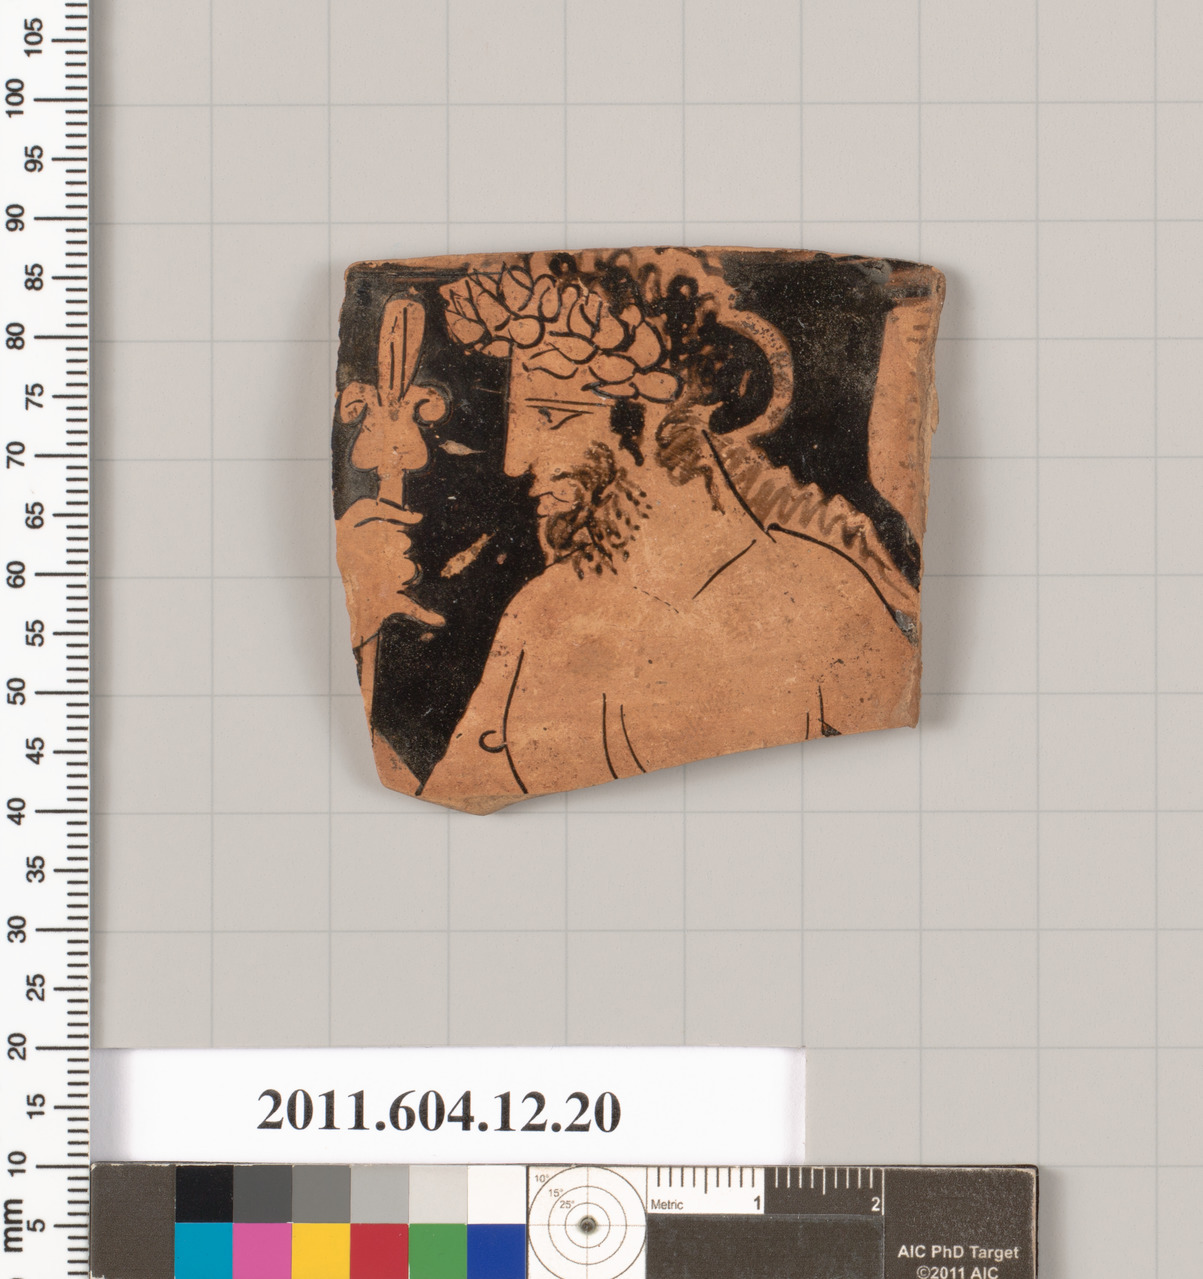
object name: undetermined closed shape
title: Terracotta fragment of a closed shape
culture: greek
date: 367-335 BCE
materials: terracotta